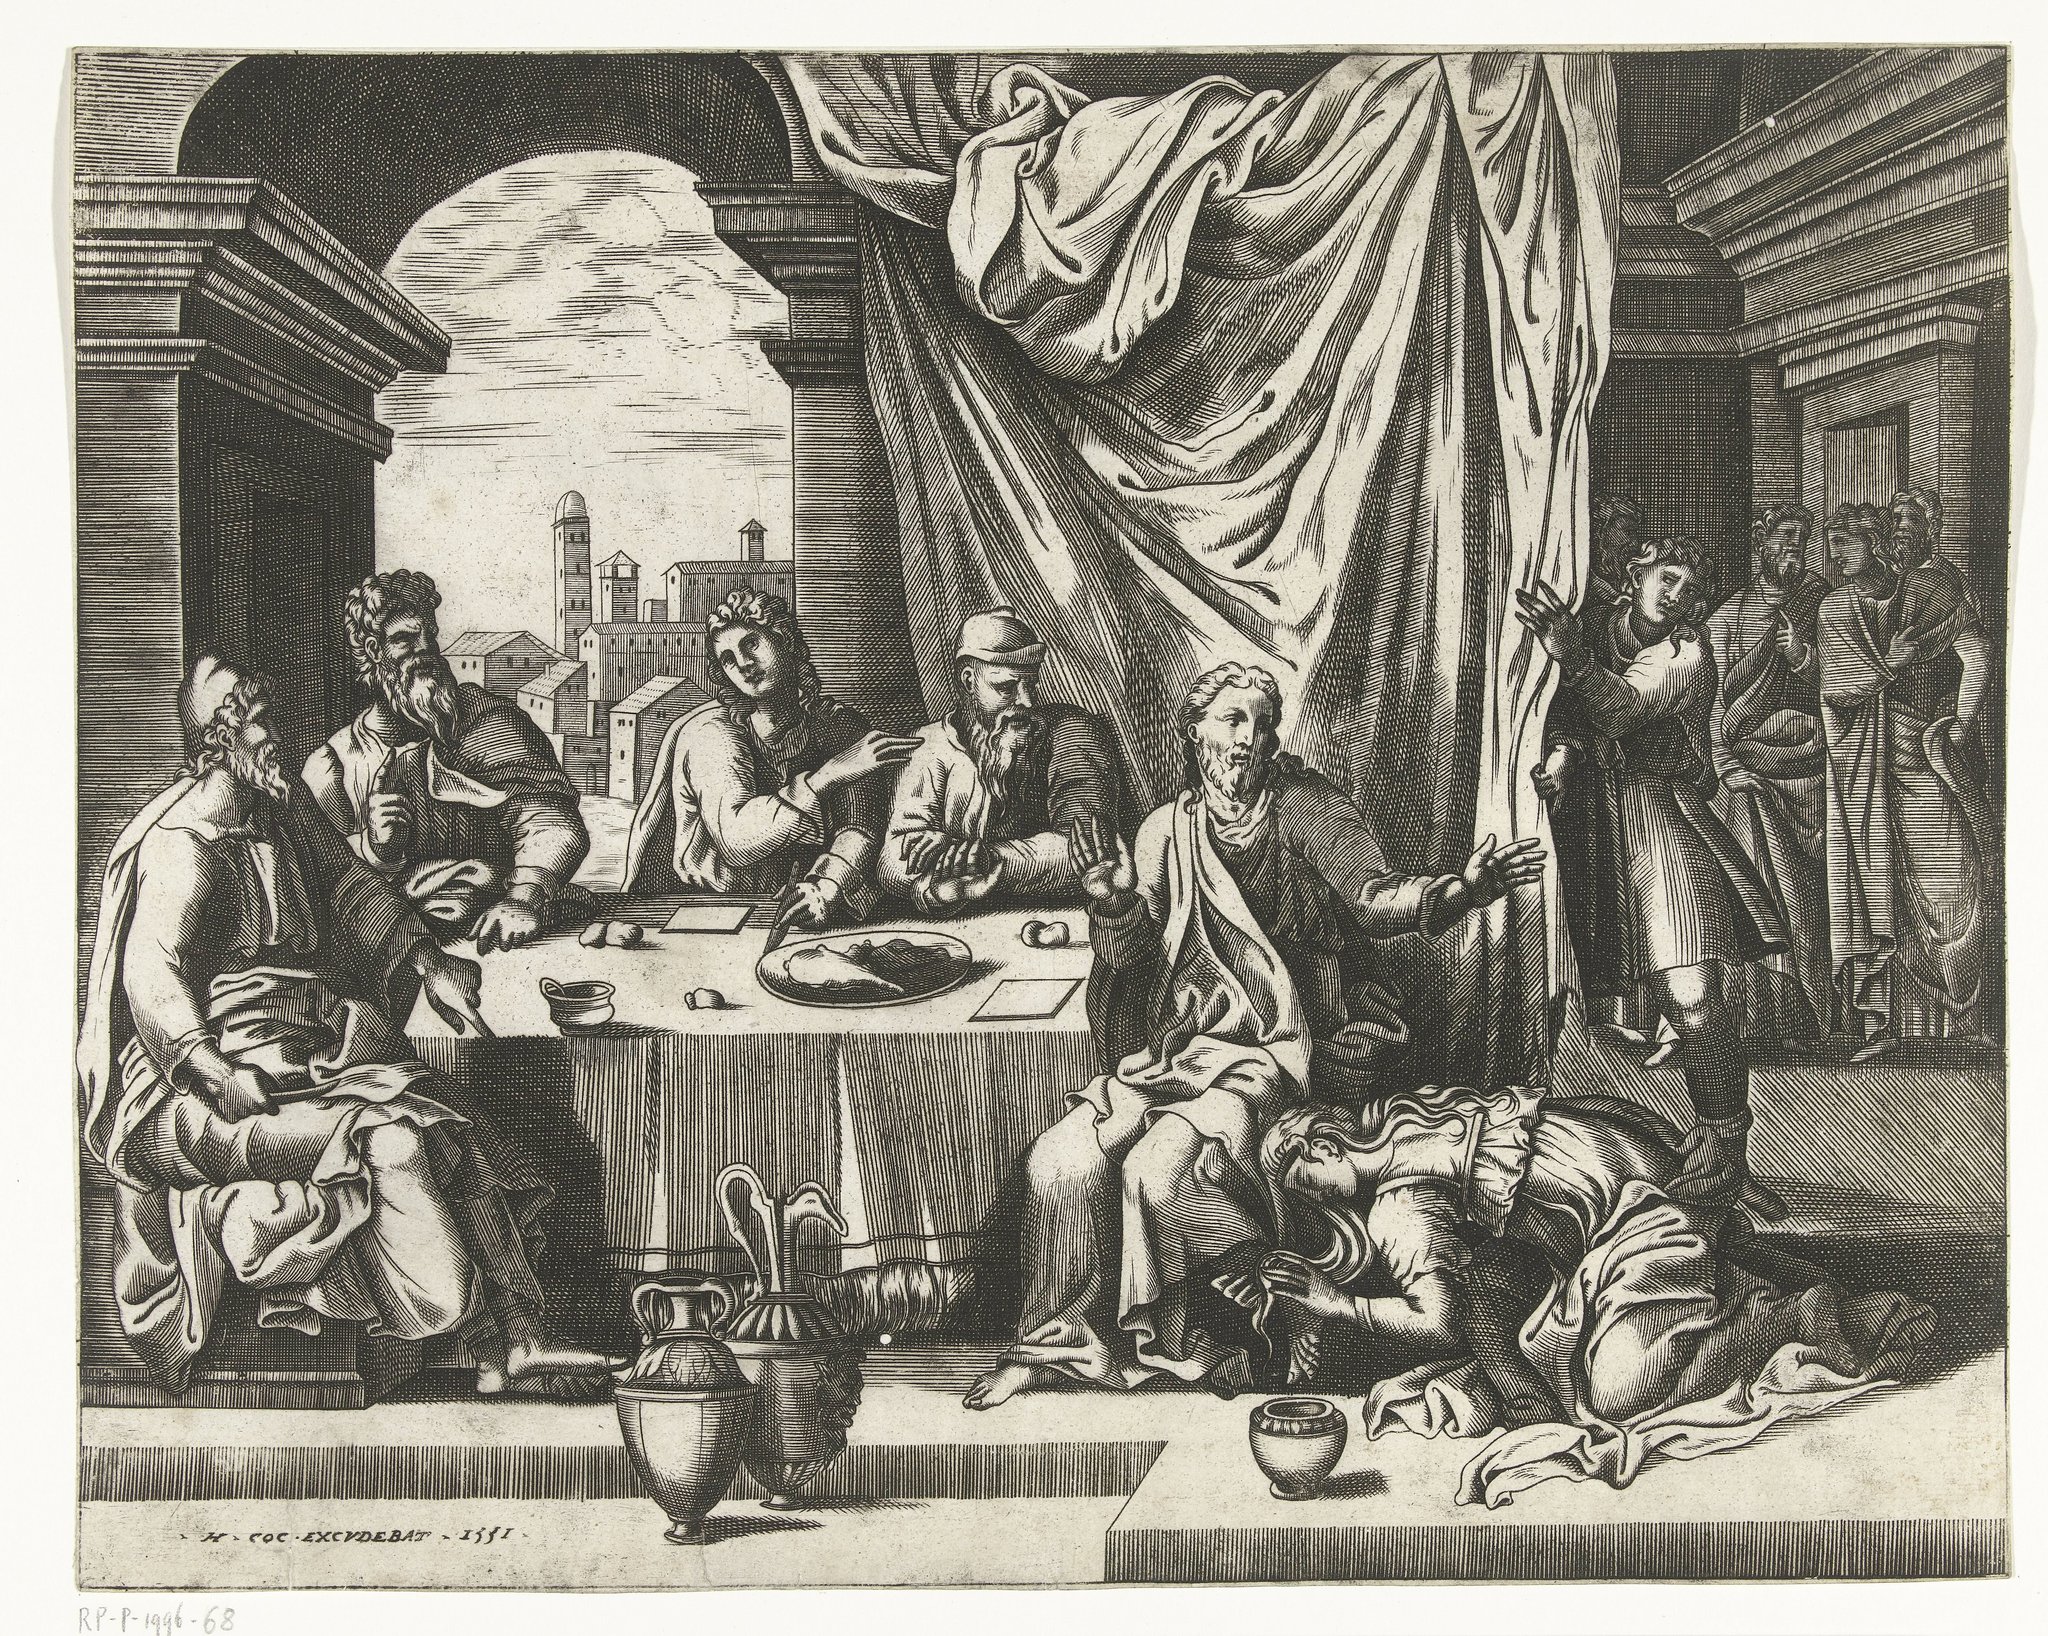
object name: print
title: Maria Magdalena zalft de voeten van Christus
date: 1551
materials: paper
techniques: engraving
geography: antwerp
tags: christ's feet are anointed by mary (magdalene)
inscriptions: collector's mark: Lugt 2228, signature and date: ‘l.o.: H. coc excudebat. 1551’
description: Christus met de Farizeën aan een tafel. Op de voorgrond Maria Magdalena op haar knieën voor Christus, zijn voeten afdrogend met haar haar. Een zalfpot op de grond. Op de achtergrond, achter een gordijn, enkele apostelen.